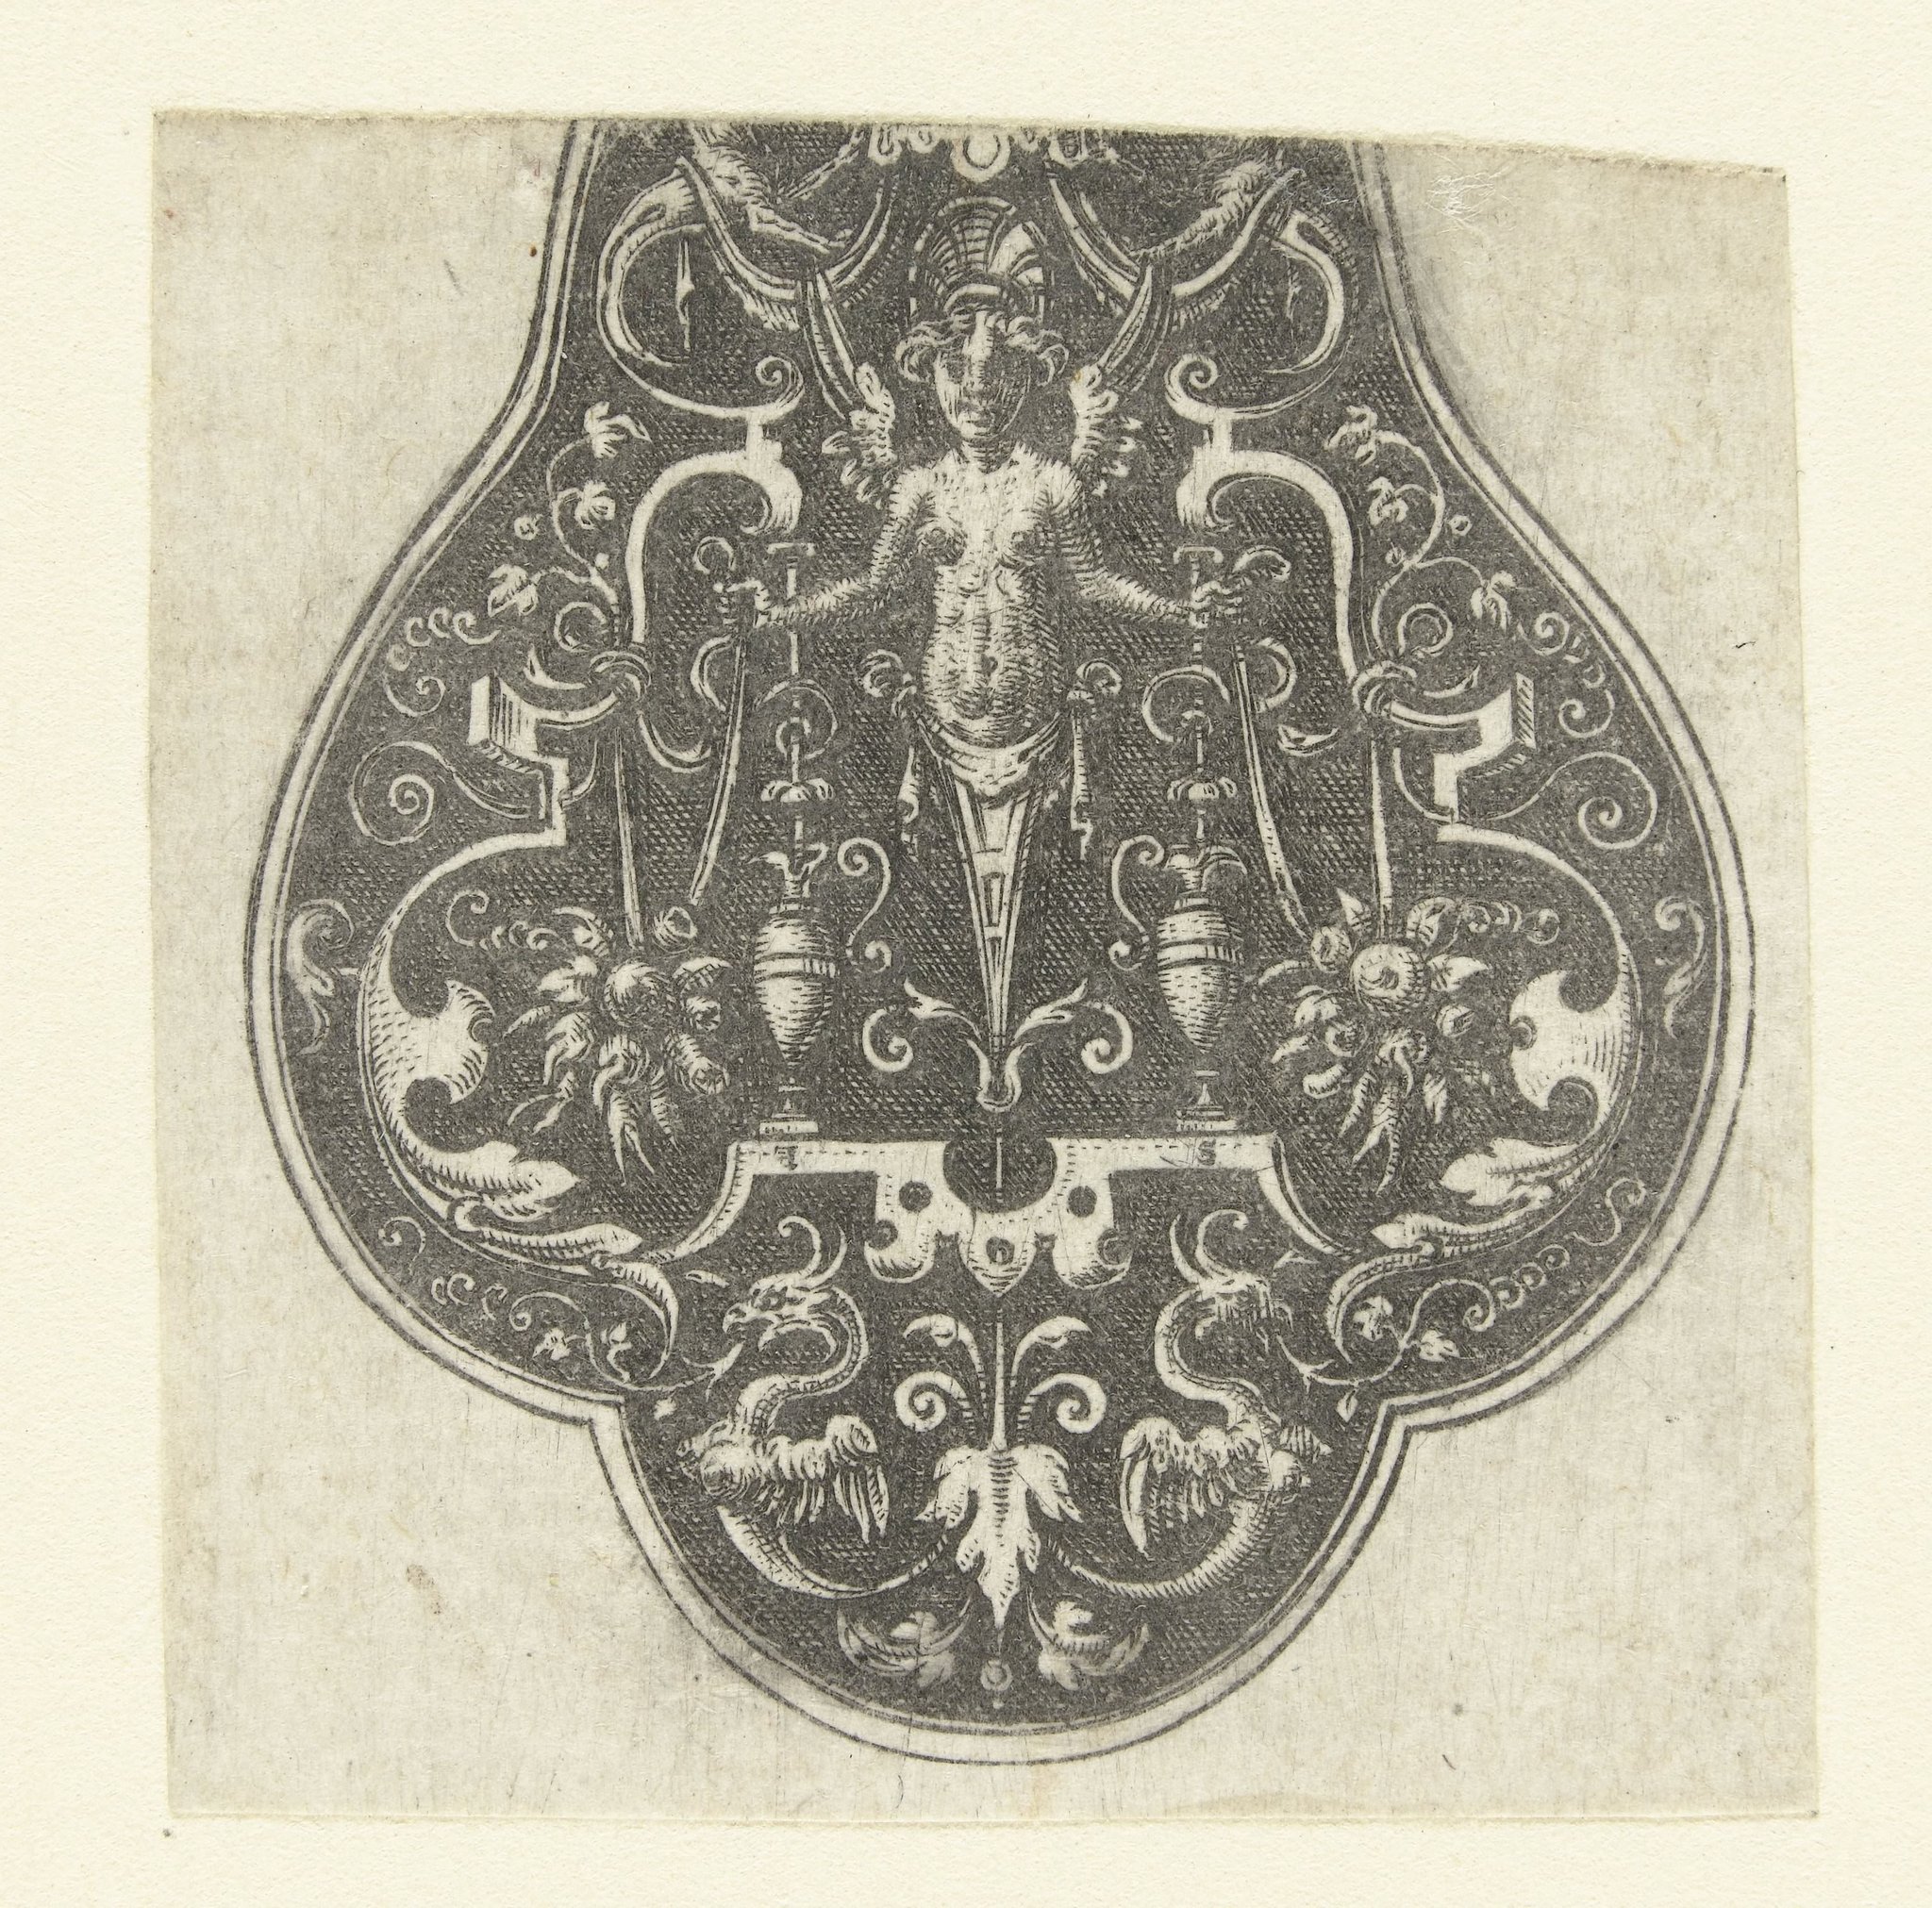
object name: ornament print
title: Ornament met vrouwelijke herme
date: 1528-1573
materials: paper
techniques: engraving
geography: france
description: De herme staat tussen twee vazen. Uit serie van 8 bladen met peervormige vlakdecoraties.